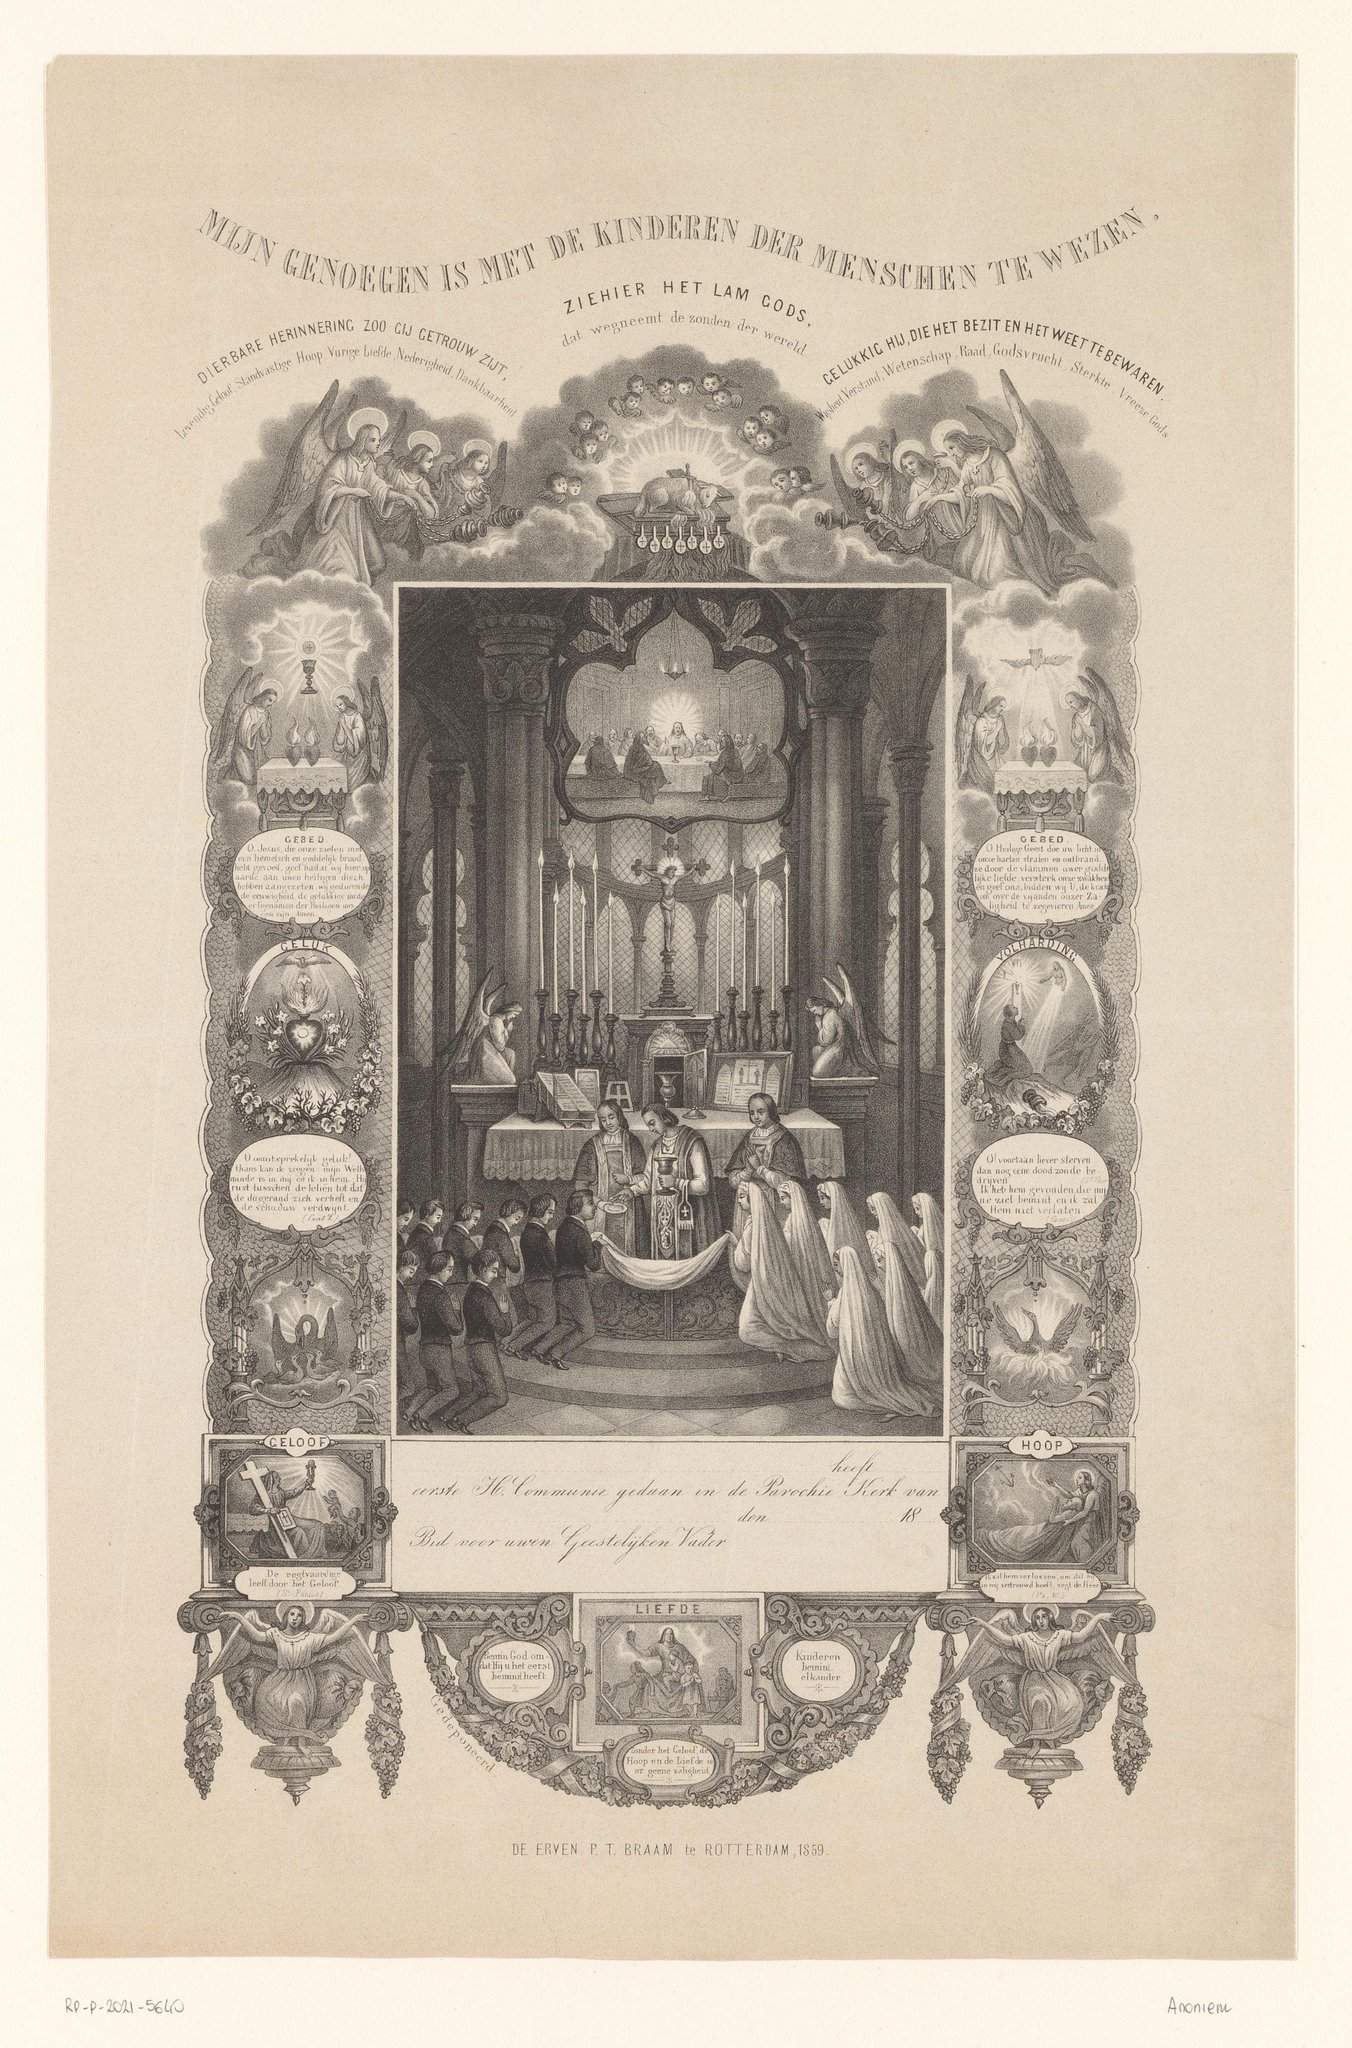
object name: print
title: Heilige communie wordt uitgedeeld aan jongens en meisjes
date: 1859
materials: paper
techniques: lithograph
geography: rotterdam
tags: first communion, altar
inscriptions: : ‘Gedeponeerd’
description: Een jongen ontvangt de heilige communie voor het altaar in een kerk. Achter hem zitten meer jongens. Rechts zit een groep meisjes in witte jurken te wachten op de hostie. De afbeelding is omlijst met taferelen die verwijzen naar scènes uit de Bijbel, allegorische scènes en teksten uit de Bijbel. Bovenin ligt het lam Gods op een altaar. Onderin een tekst met daarin ruimte om naam, plaats en datum in te vullen.